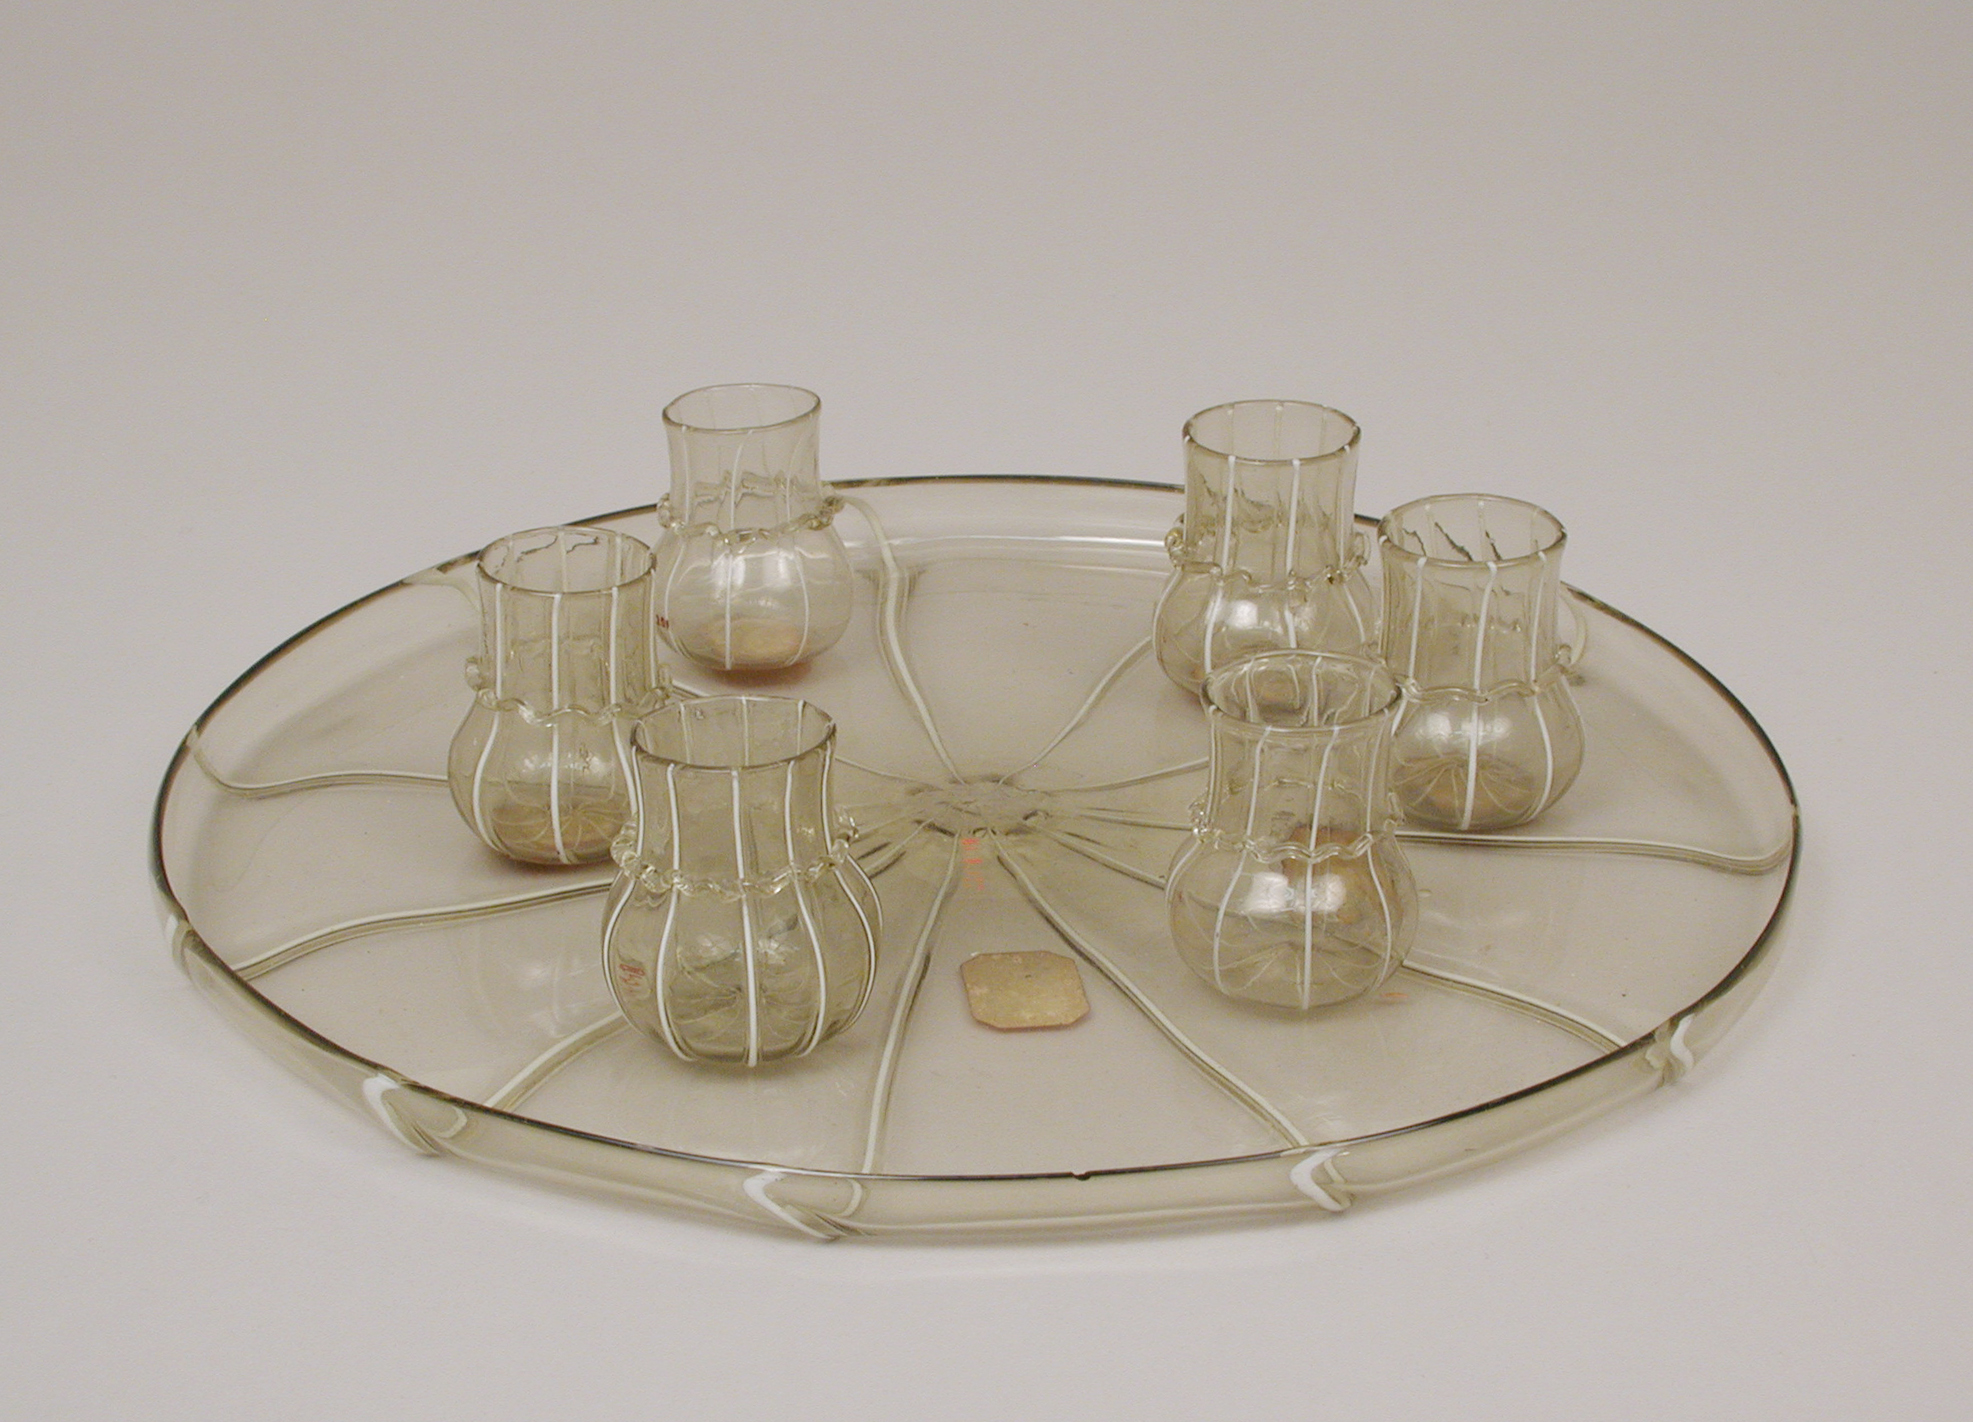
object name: schnapps set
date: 1701-1900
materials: glass